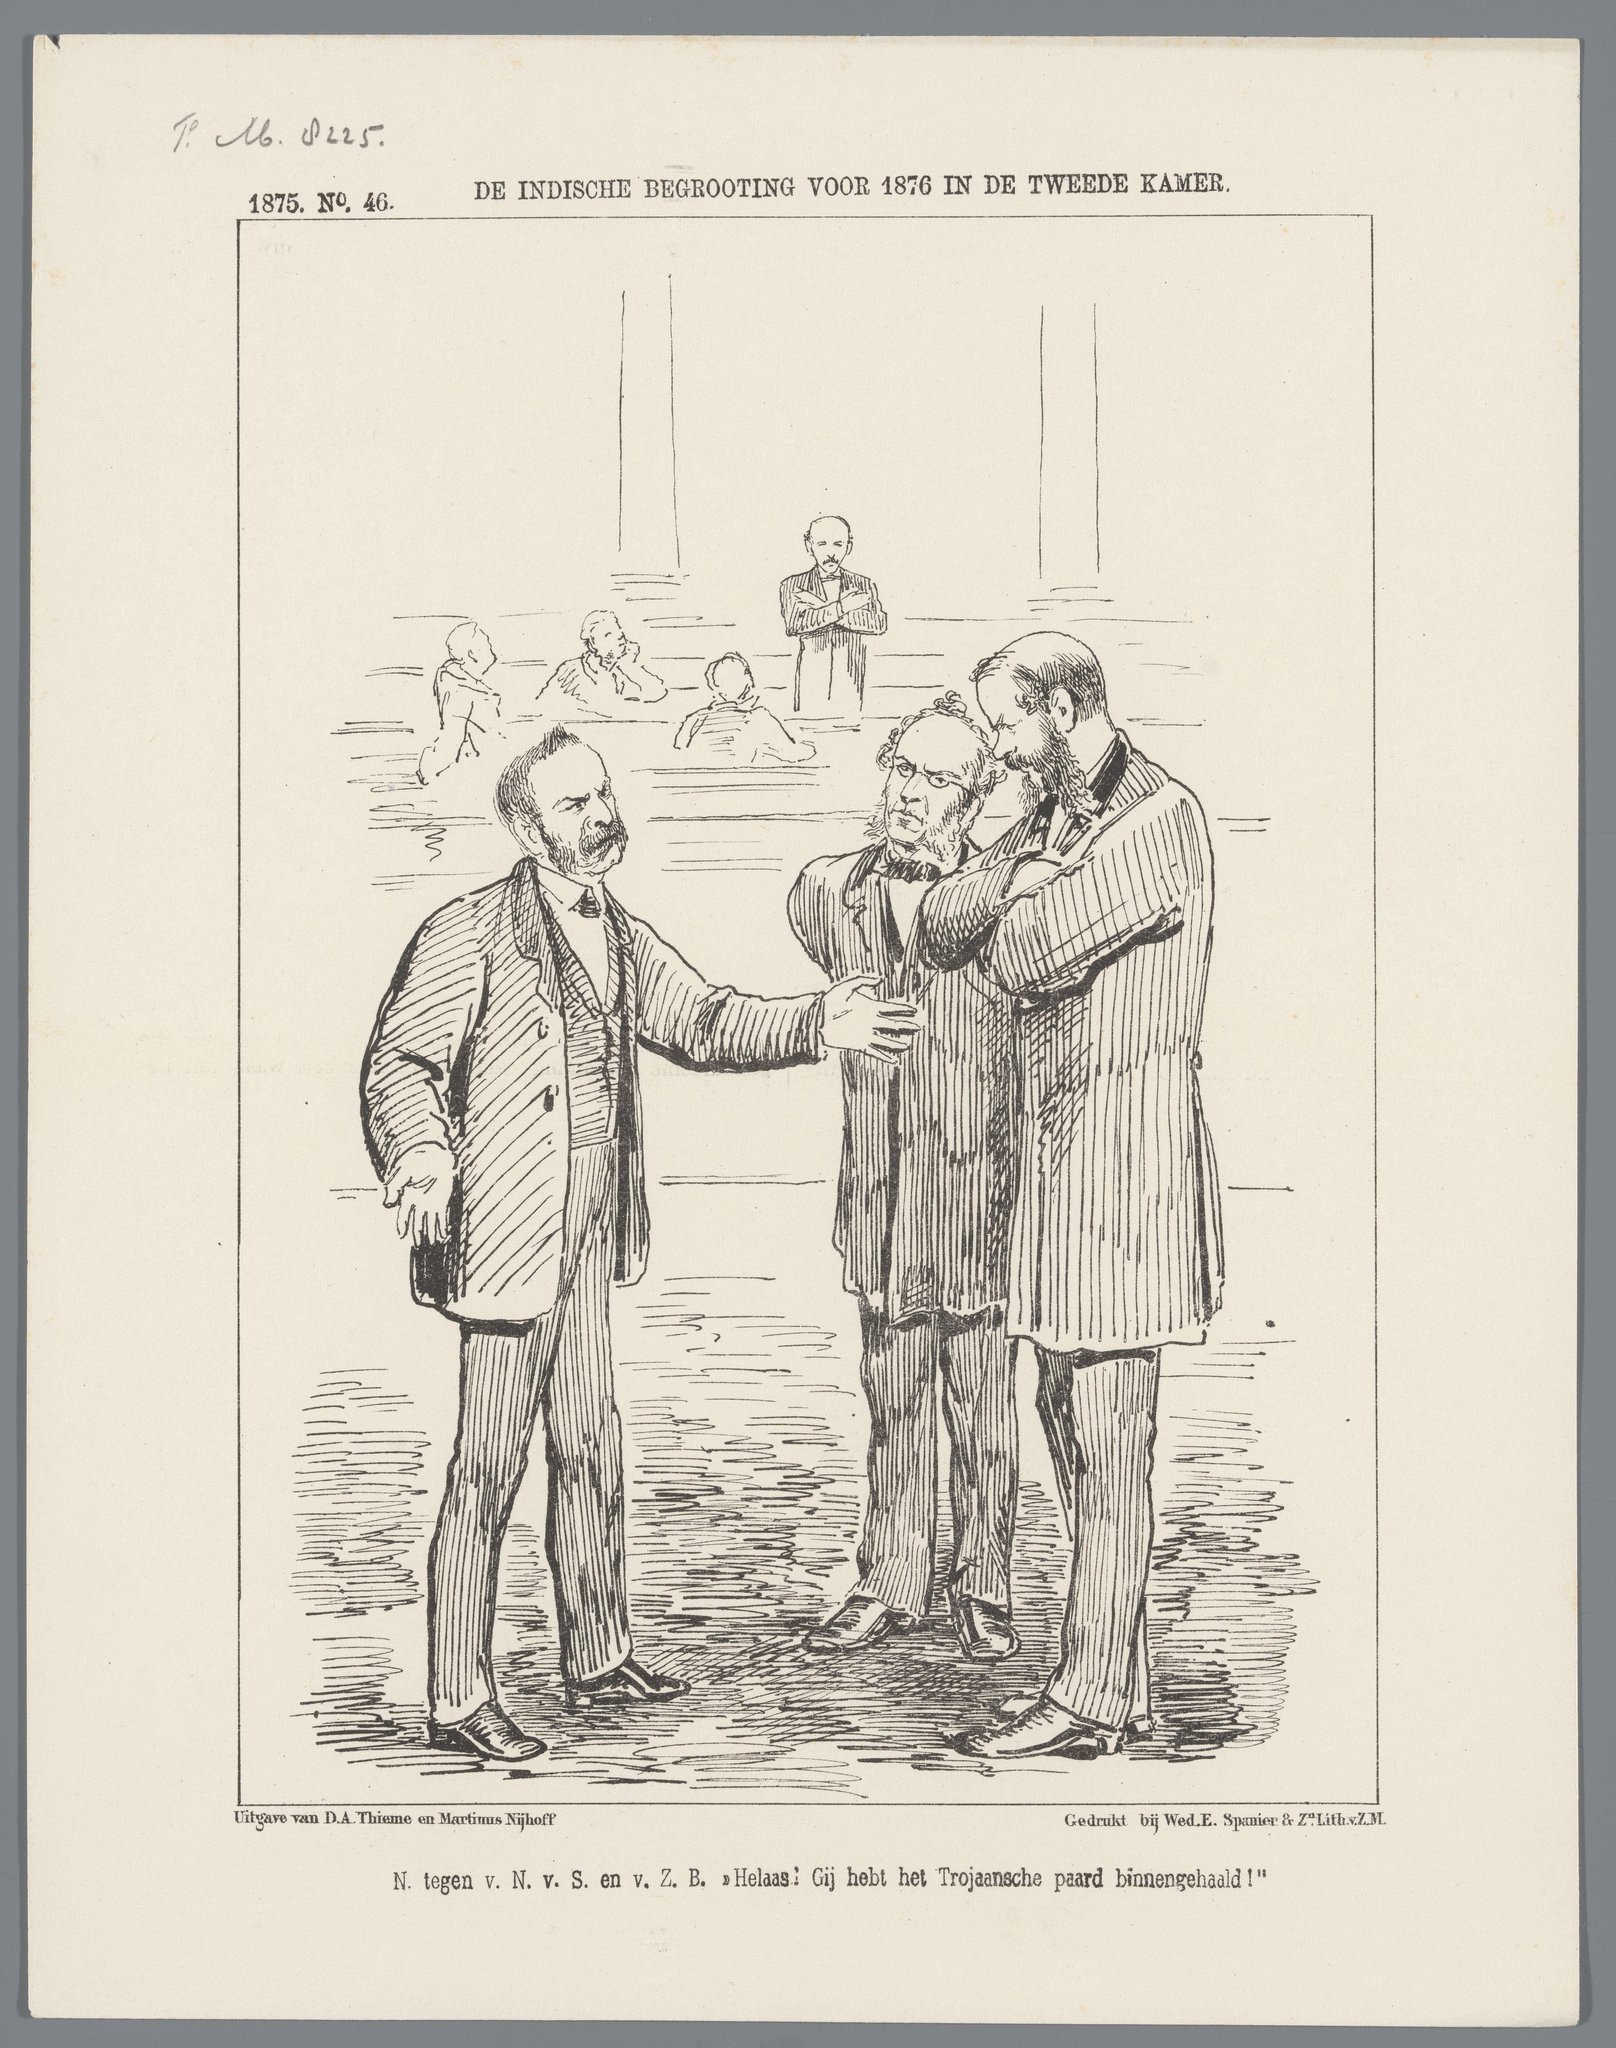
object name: cartoon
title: De Indische begrooting voor 1876 in de Tweede Kamer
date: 1875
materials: paper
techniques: lithograph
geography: netherlands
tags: tweede kamerlid, herman agatho des amorie van der hoeven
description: Spotprent op de verkiezing van H.A. des Amorie van der Hoeven tot lid van de Tweede Kamer, 1875 . Plaat verschenen bij het weekblad De Nederlandsche Spectator, nr. 46, 1875.